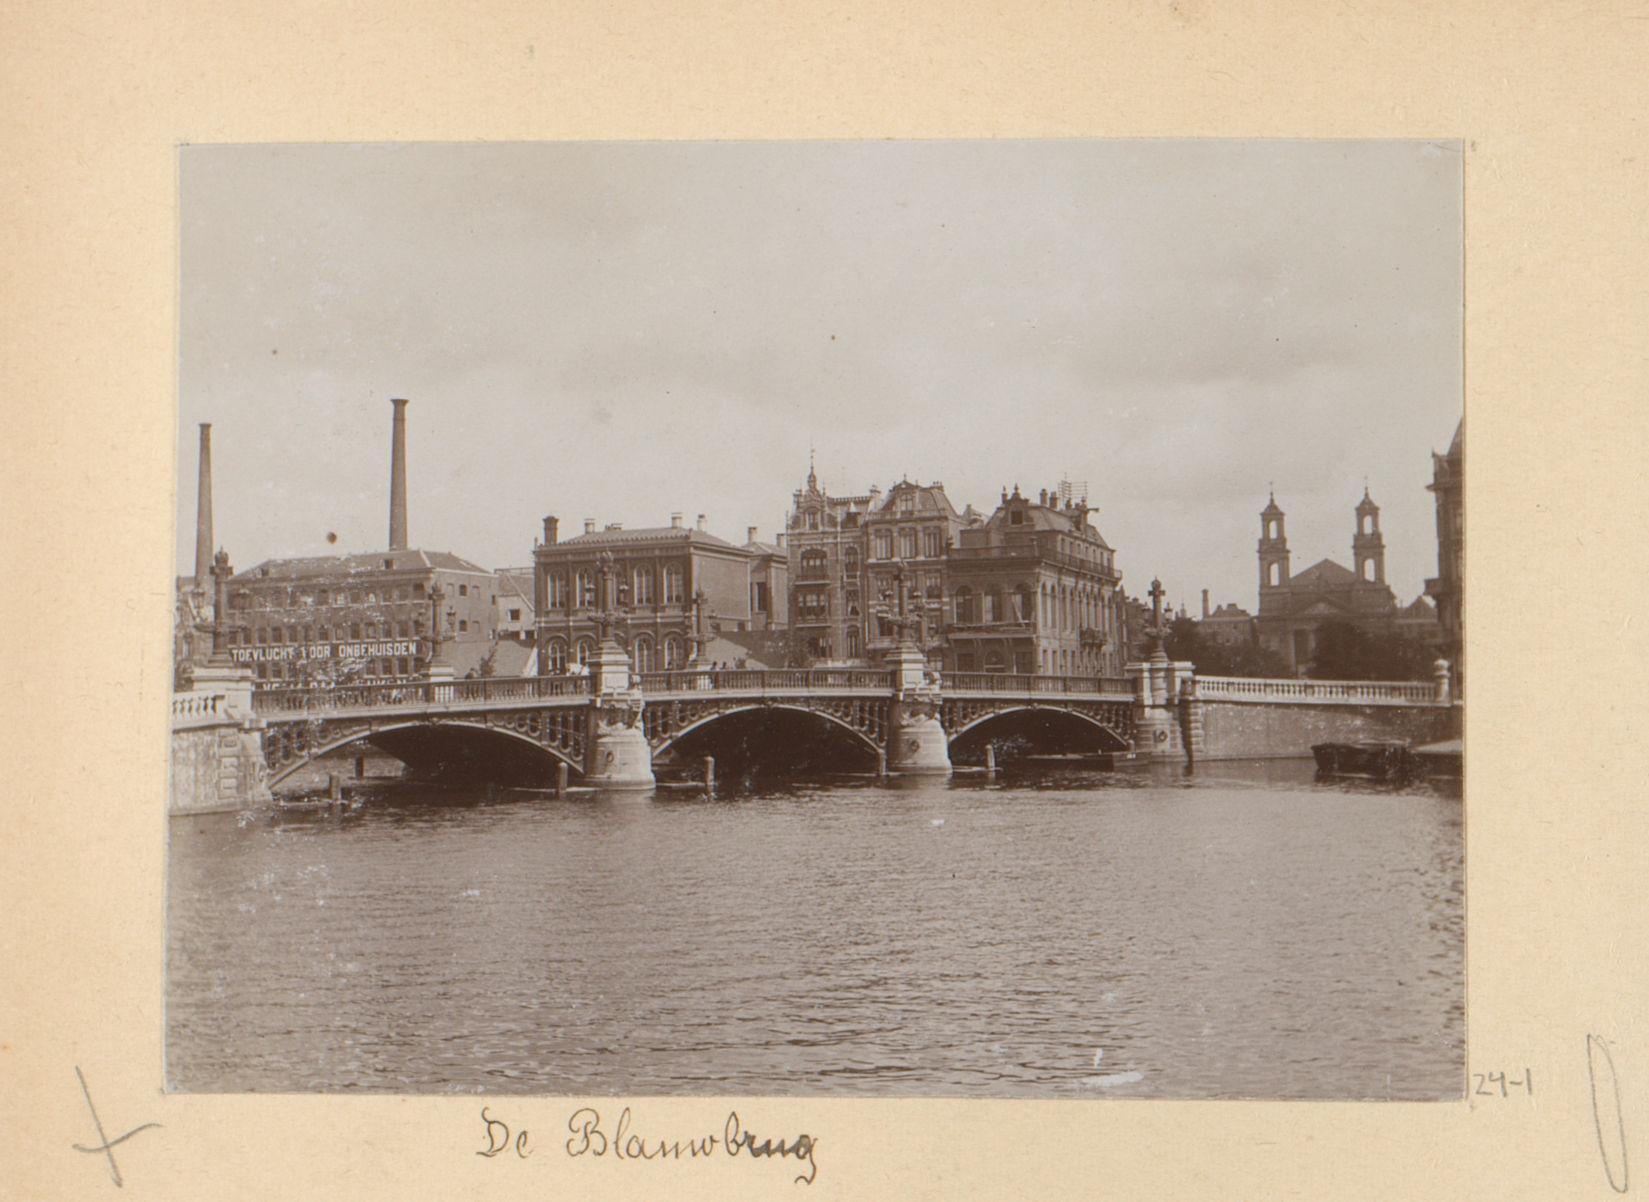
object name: photograph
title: Gezicht op de Blauwbrug te Amsterdam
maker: hendrik herman van den berg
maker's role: amateurfotograaf, jurist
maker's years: 1875-1944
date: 1890-1894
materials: paper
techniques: collodion silver print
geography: amsterdam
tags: bridge in city across river, canal, etc.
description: Foto 1 op albumblad 24 uit album "Amsterdam 1890-1894".